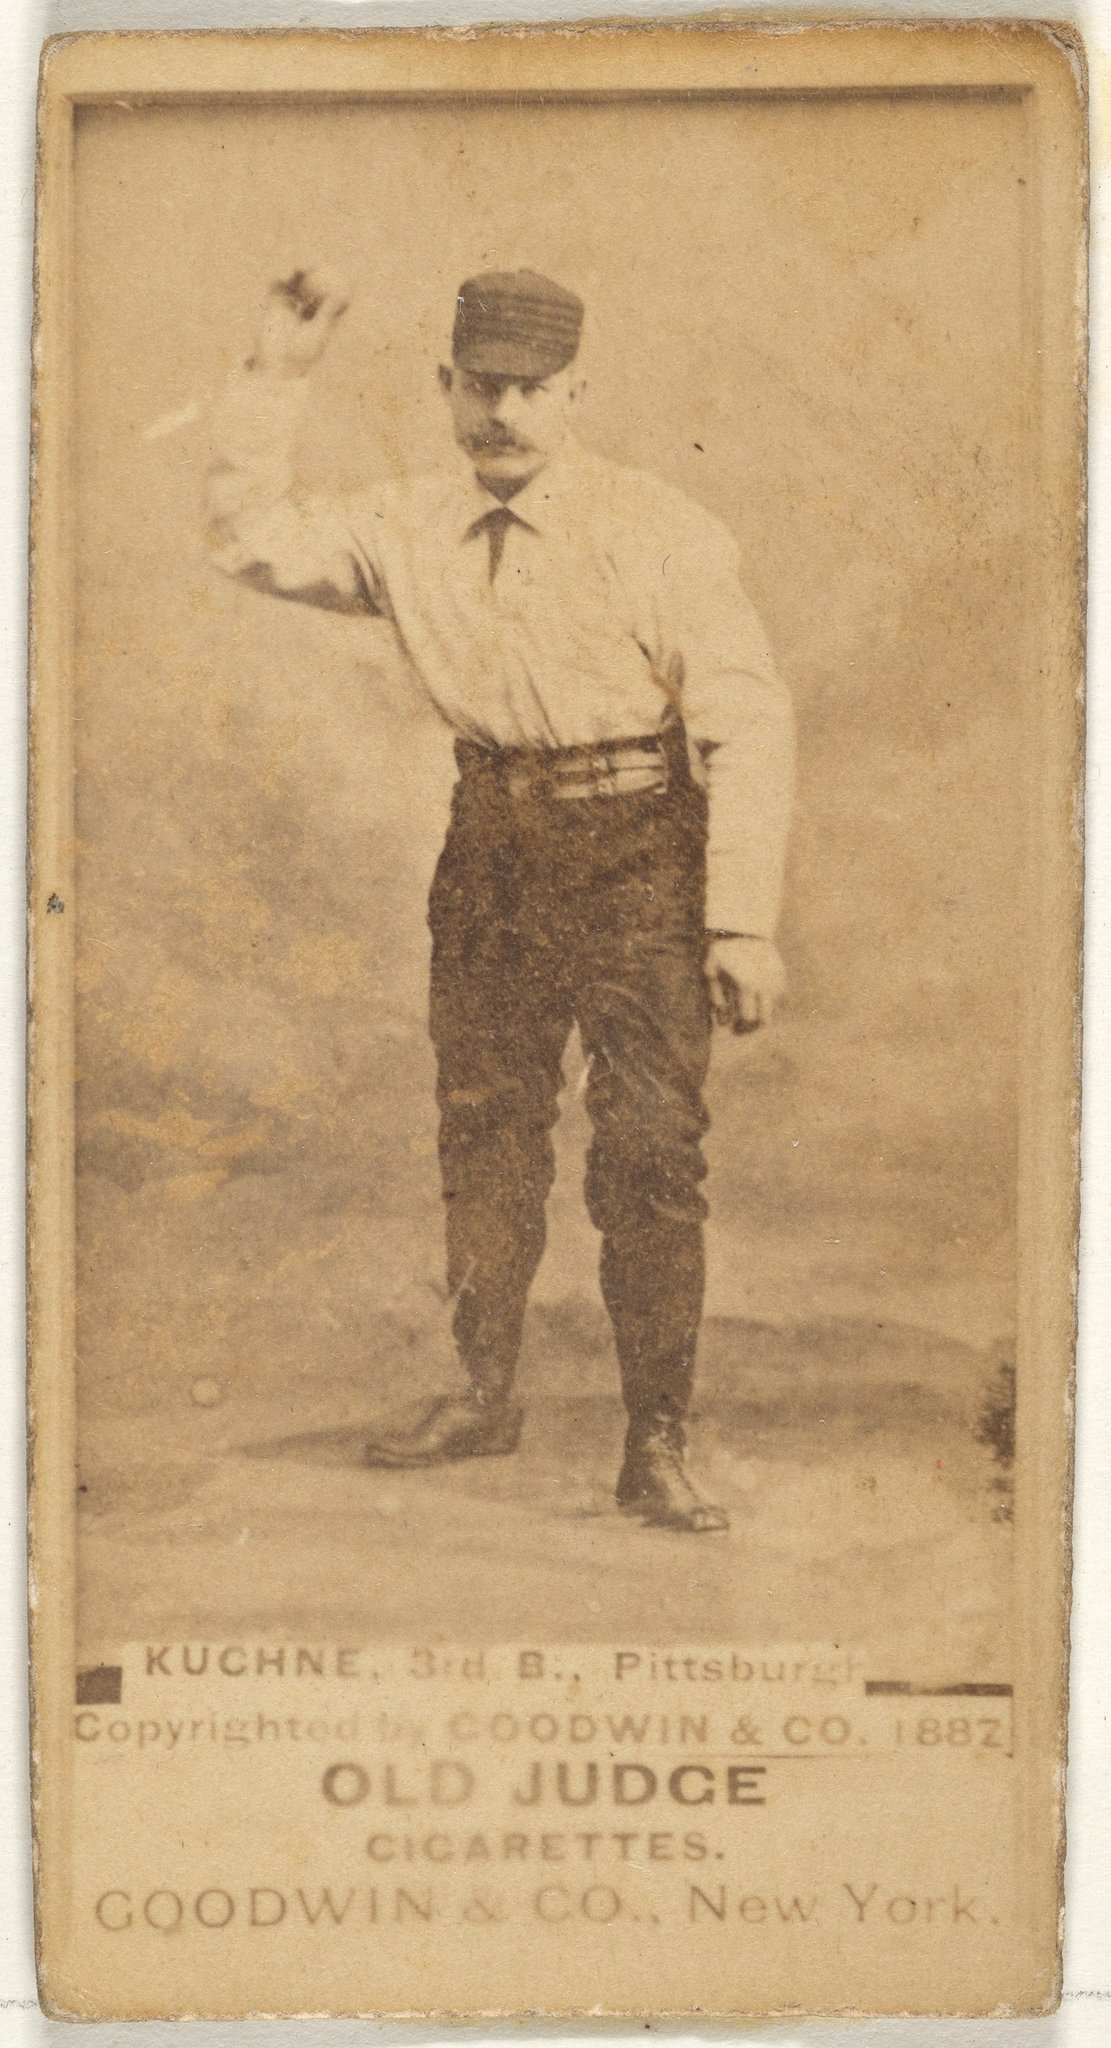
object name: baseball card, photograph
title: Bill Kuehne, 3rd Base, Pittsburgh, from the Old Judge series (N172) for Old Judge Cigarettes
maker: goodwin & company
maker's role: publisher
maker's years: 1850-1950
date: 1887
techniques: albumen silver print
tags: men,portraits,baseball,athletes